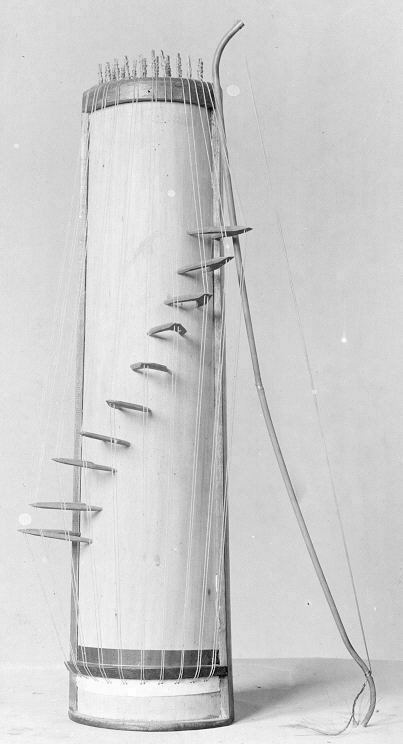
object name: laqin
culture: chinese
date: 1801-1900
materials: iron, wood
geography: china